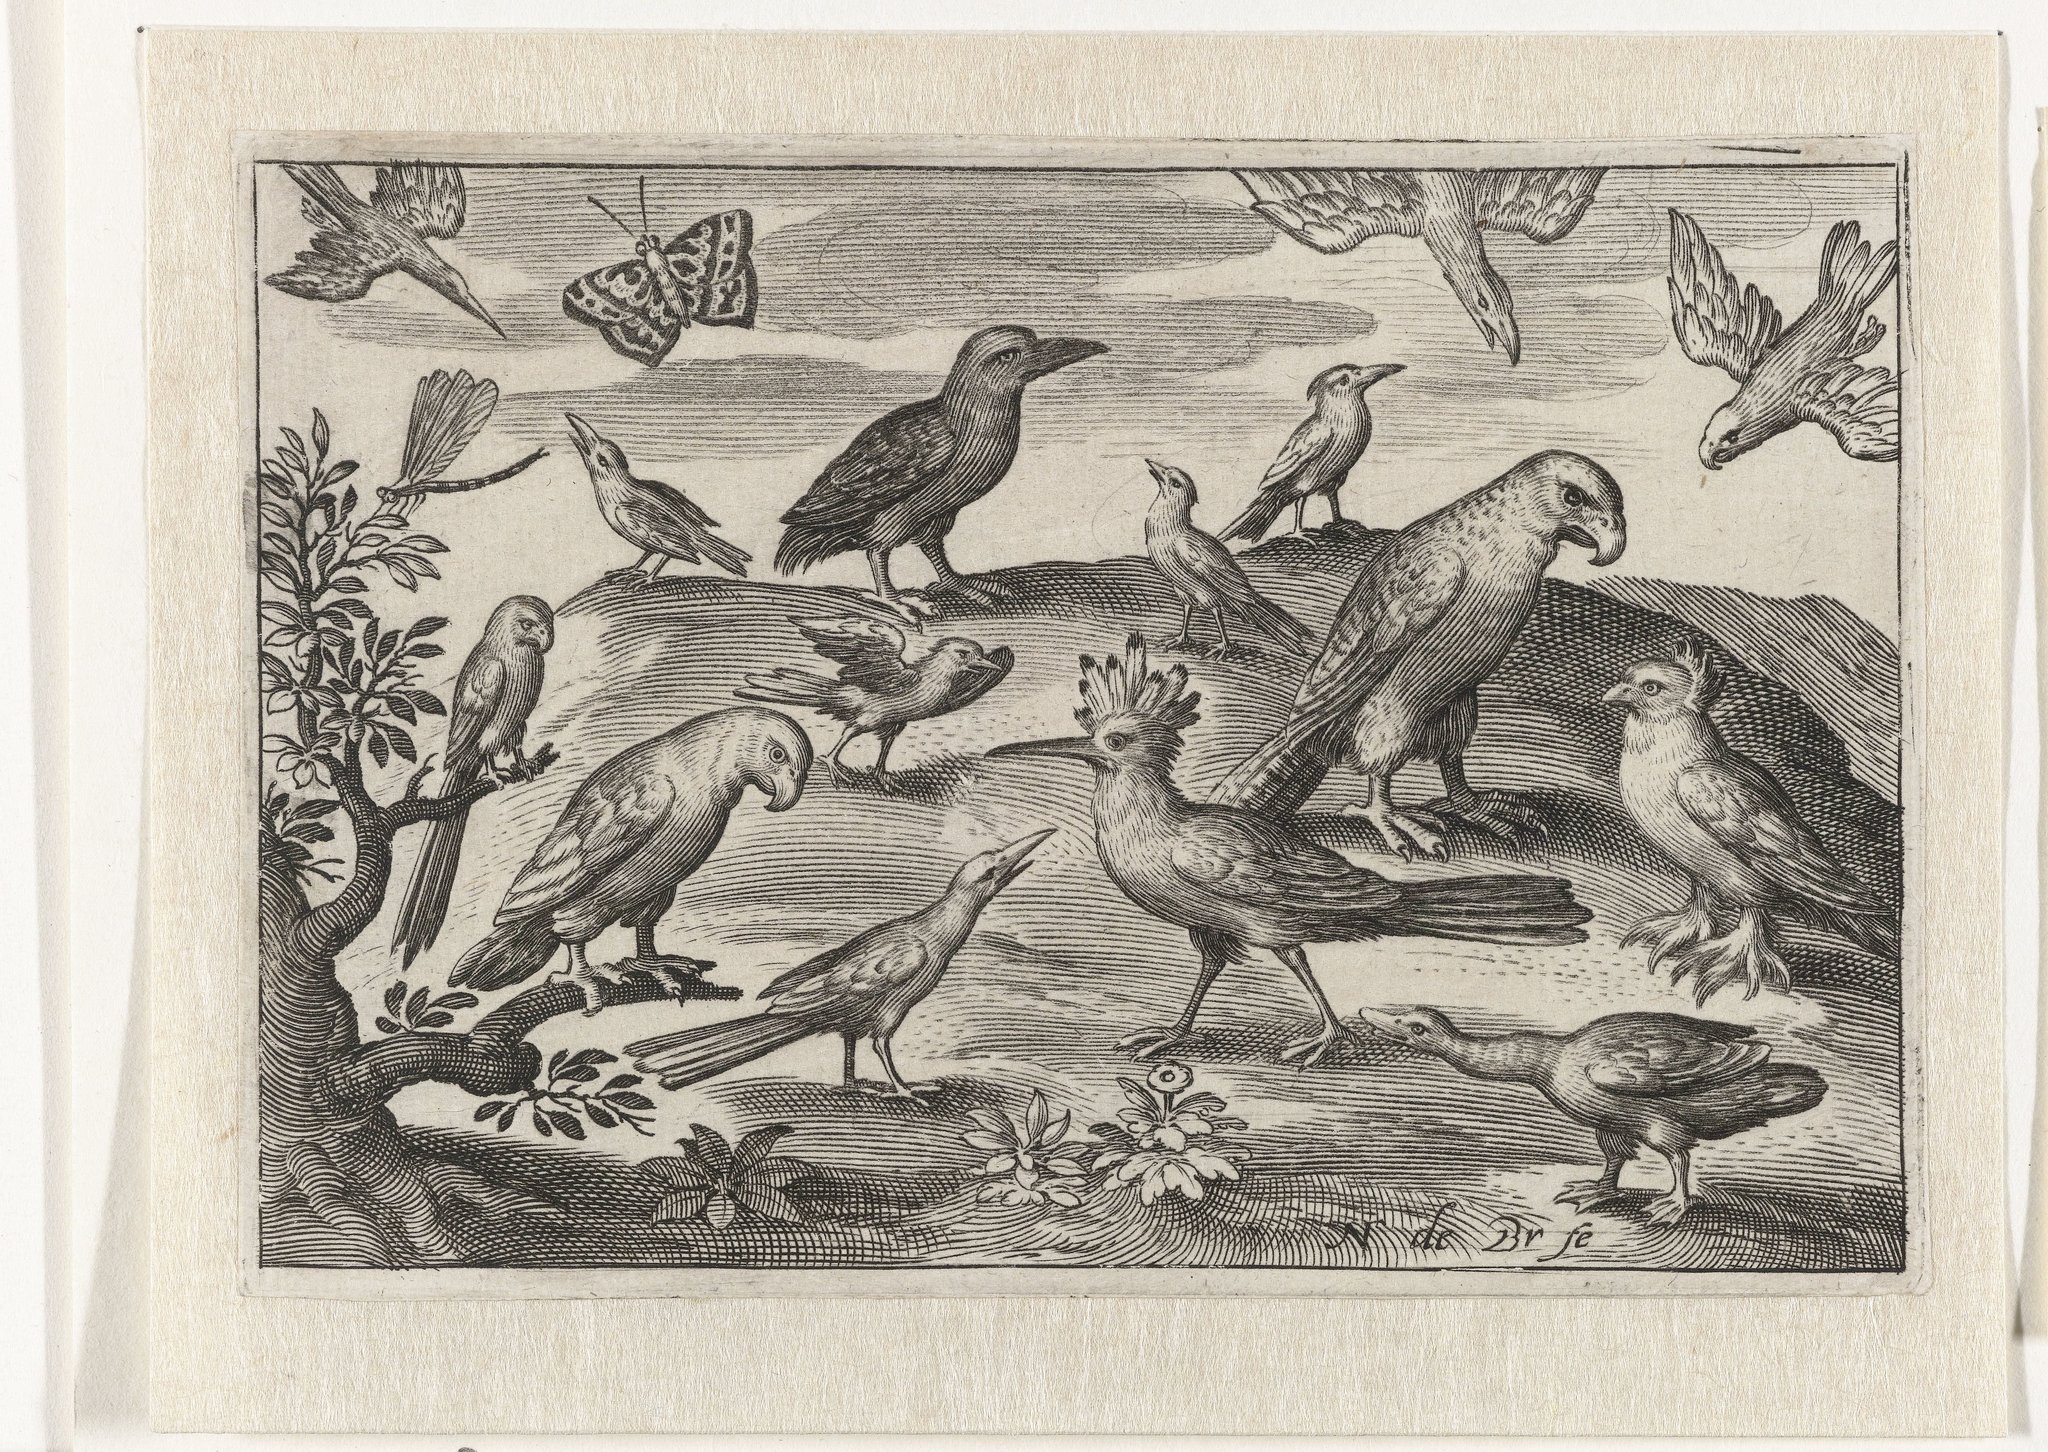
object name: print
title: Hop en andere vogels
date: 1594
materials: paper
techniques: engraving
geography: antwerp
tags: birds, other birds: hoopoe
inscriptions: collector's mark: Lugt 2228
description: Prent uit serie van twaalf prenten met vogels en insecten. Bij Hollstein zijn bladen van een andere serie prenten afgebeeld, zie De Groot 1988, p. 37.